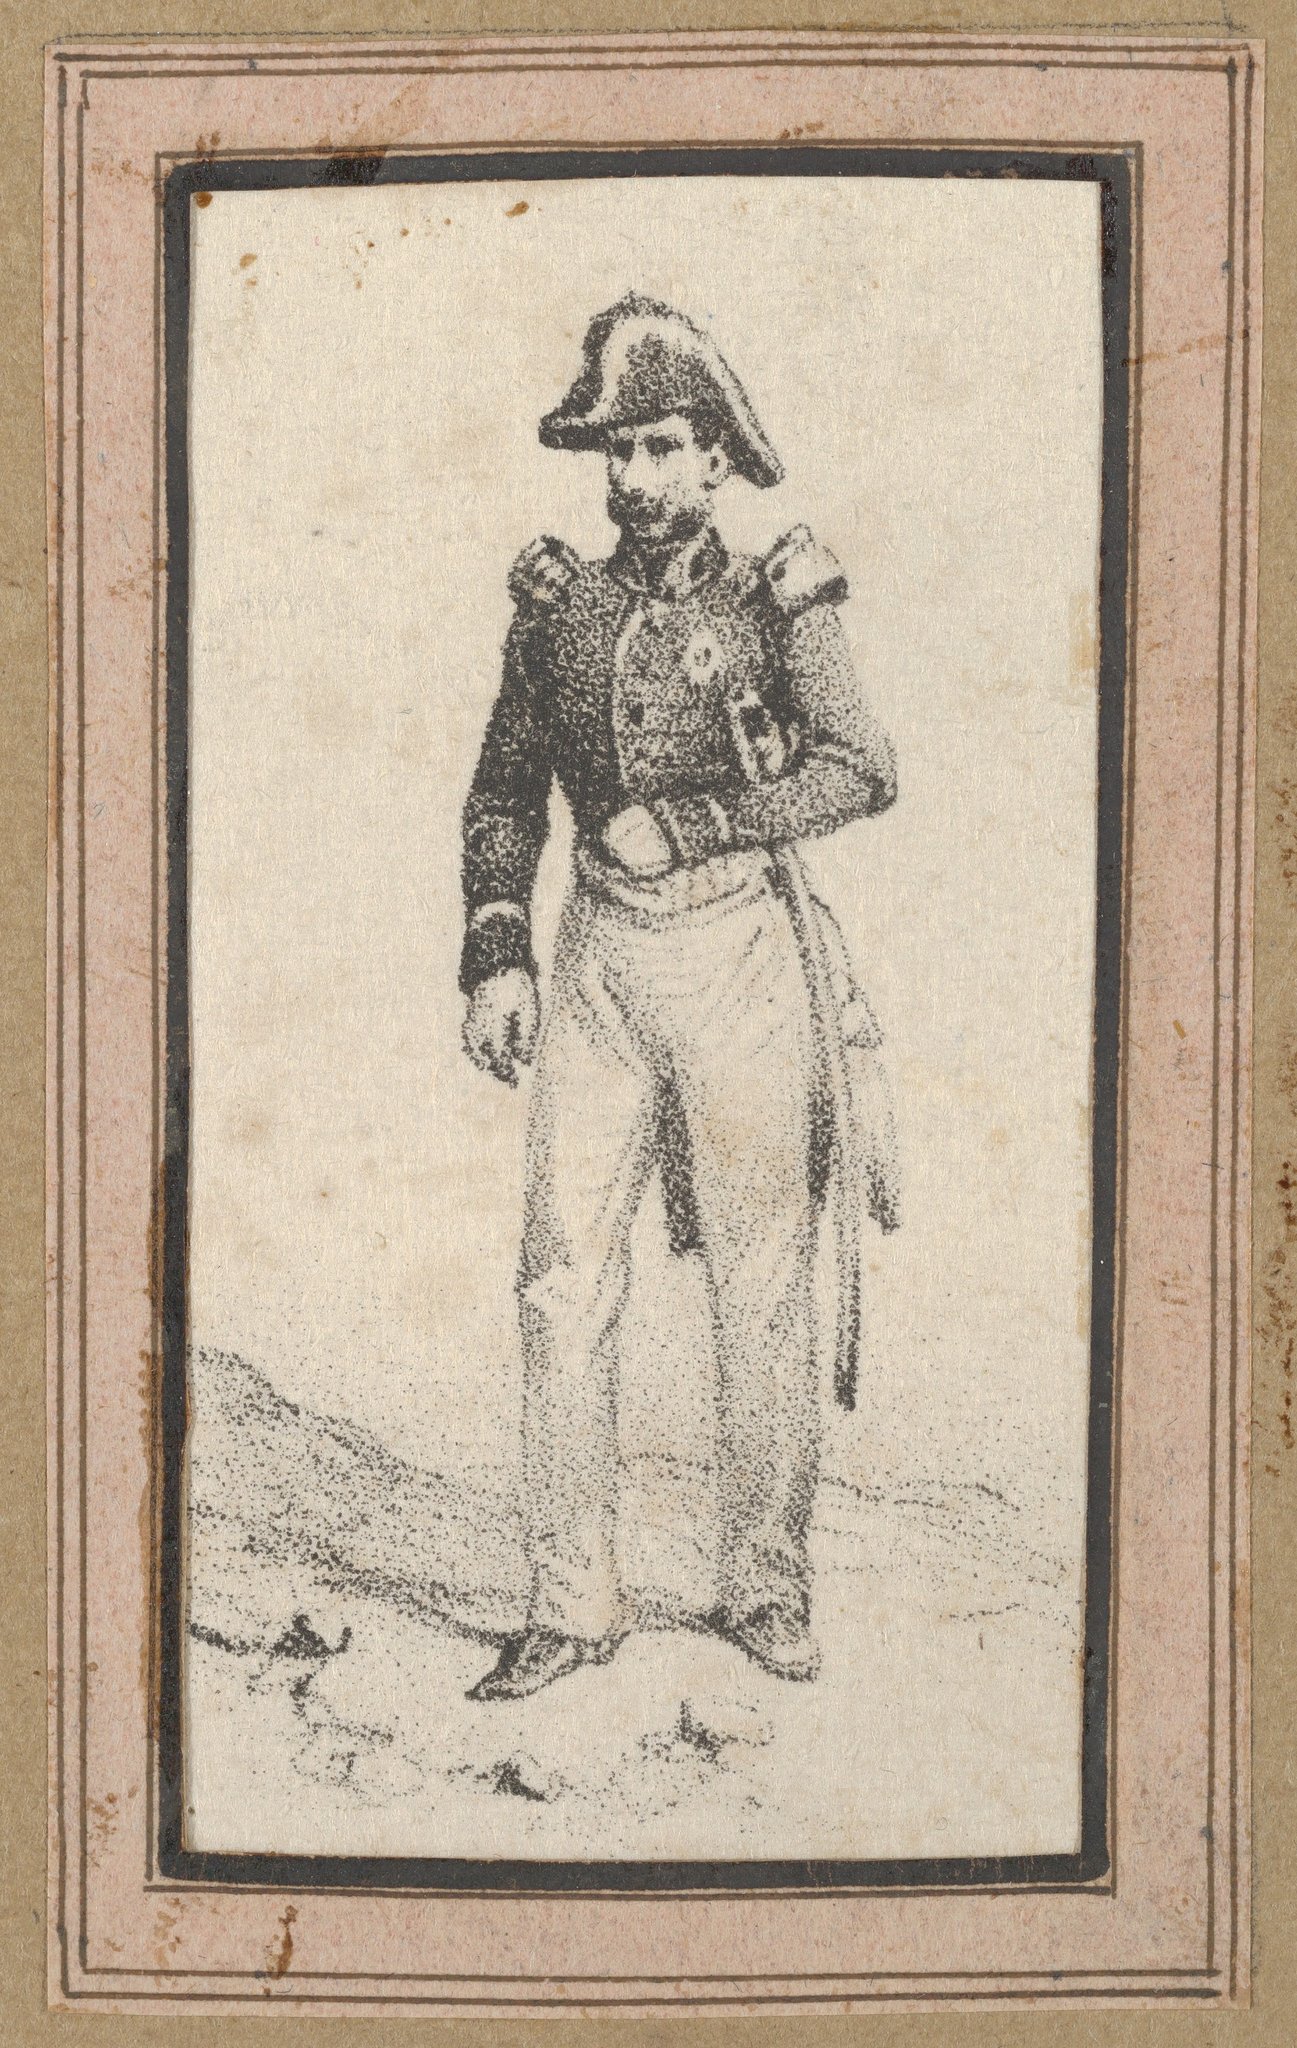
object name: print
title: A soldier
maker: victor adam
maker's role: artist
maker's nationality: french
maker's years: 1801-1866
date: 1834-1866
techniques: lithograph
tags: soldiers,men